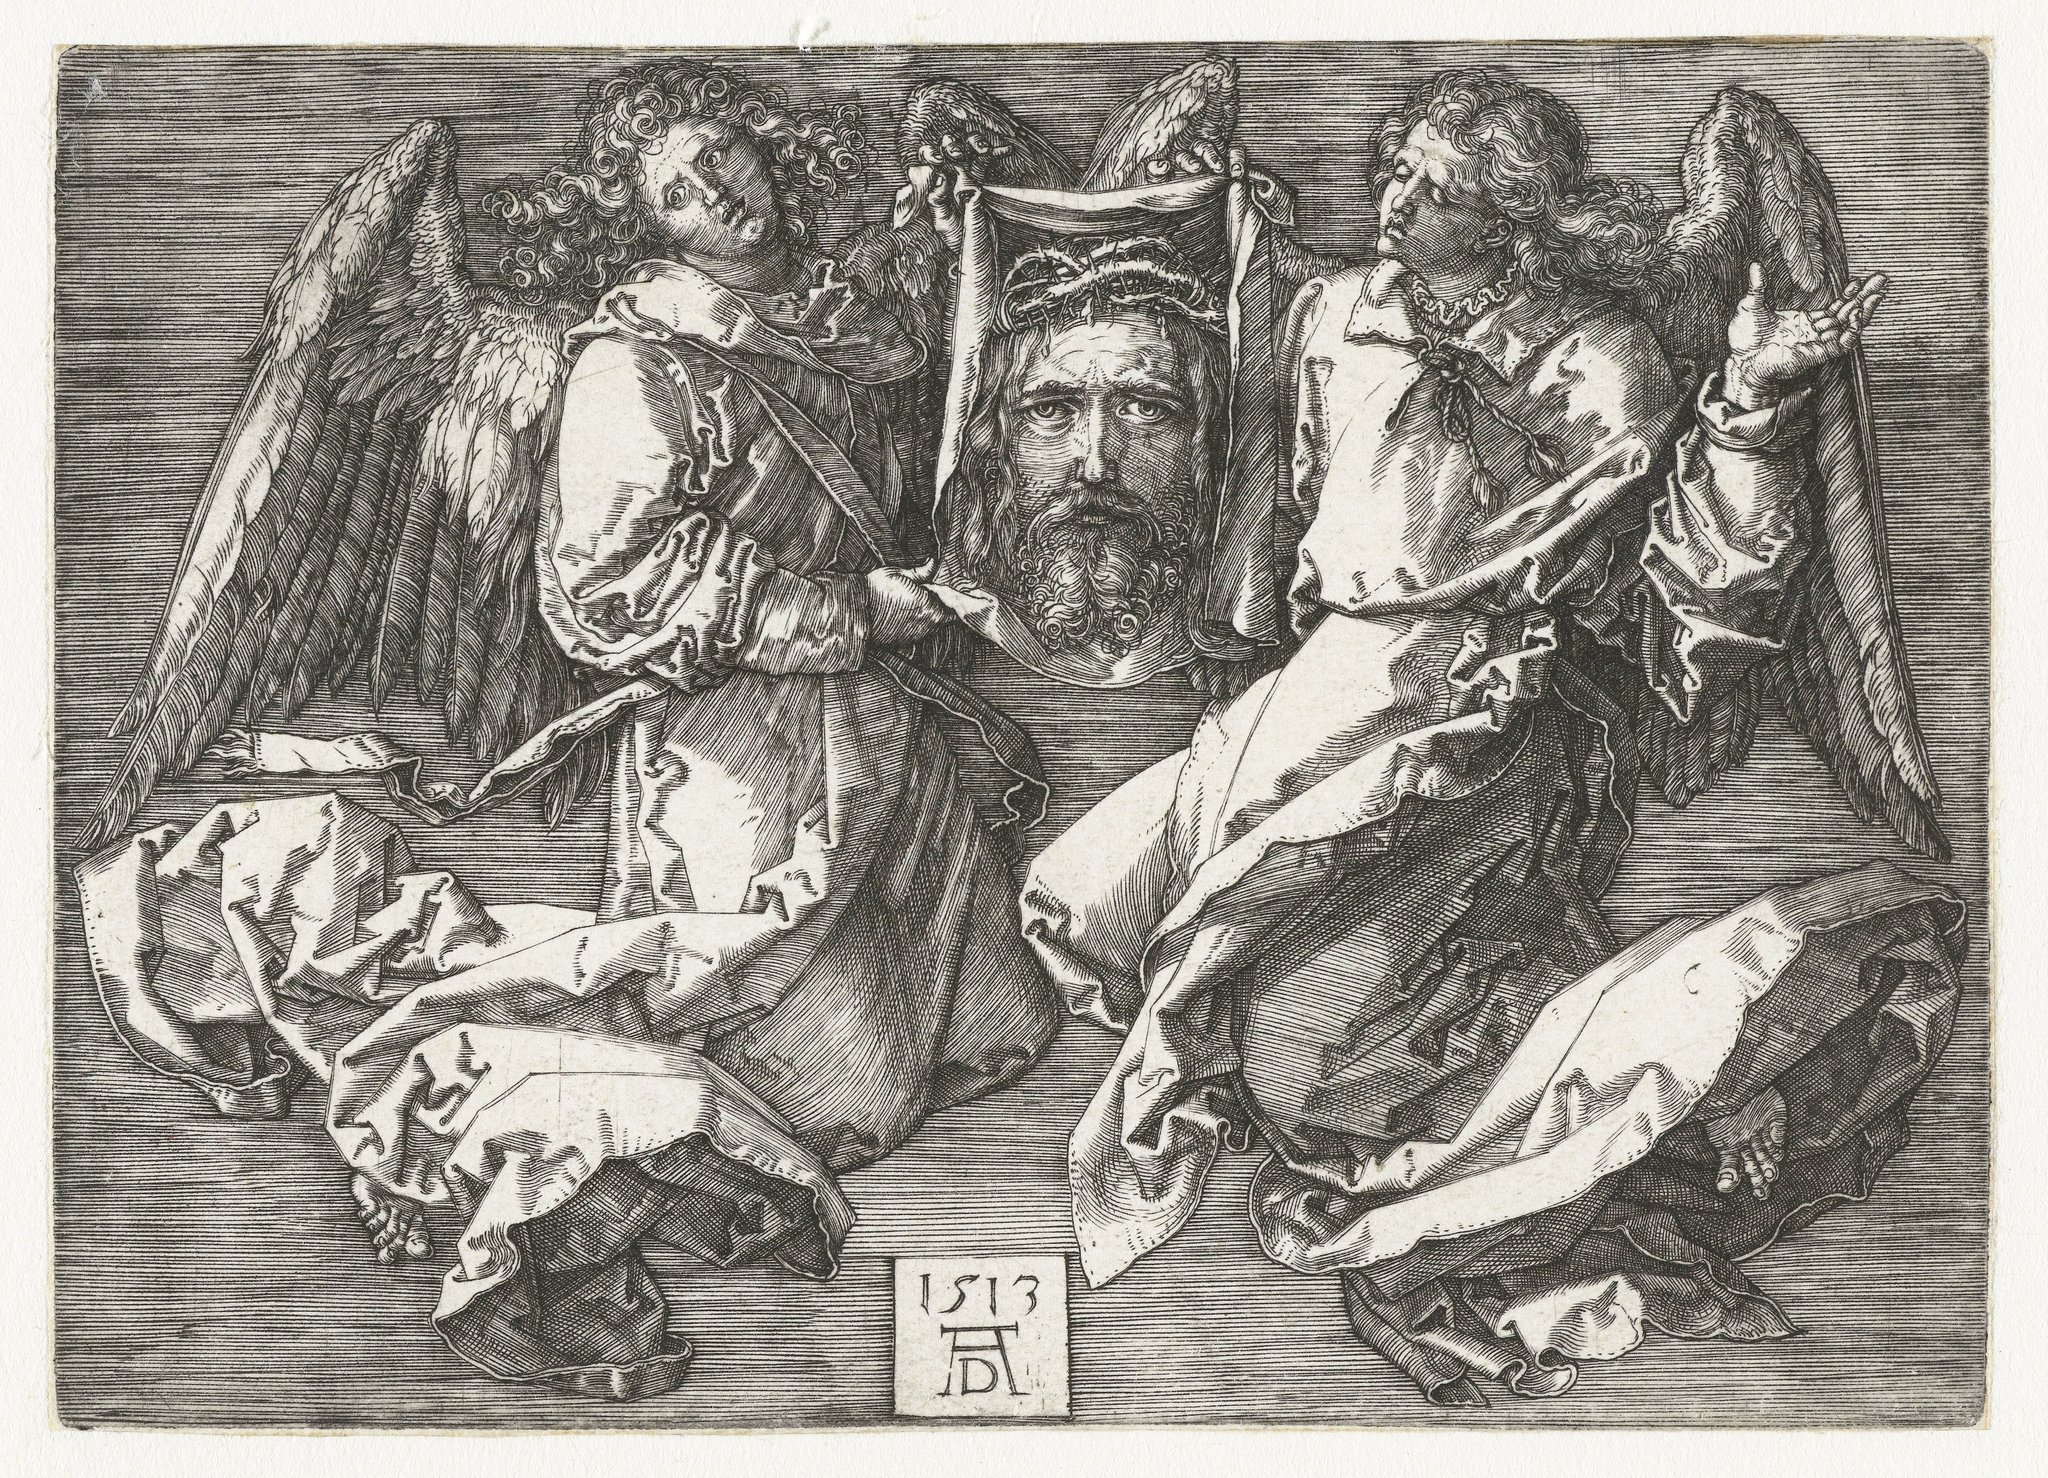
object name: print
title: Twee engelen met de zweetdoek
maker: albrecht dürer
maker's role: draughtsman, painter, print maker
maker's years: 1471-1528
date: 1513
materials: paper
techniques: engraving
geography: nuremberg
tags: 'vera icon', held up by angels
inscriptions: collector's mark: Lugt 240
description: Twee engelen houden de zweetdoek van Veronica met de afdruk van het gelaat van Christus vast (het sudarium).